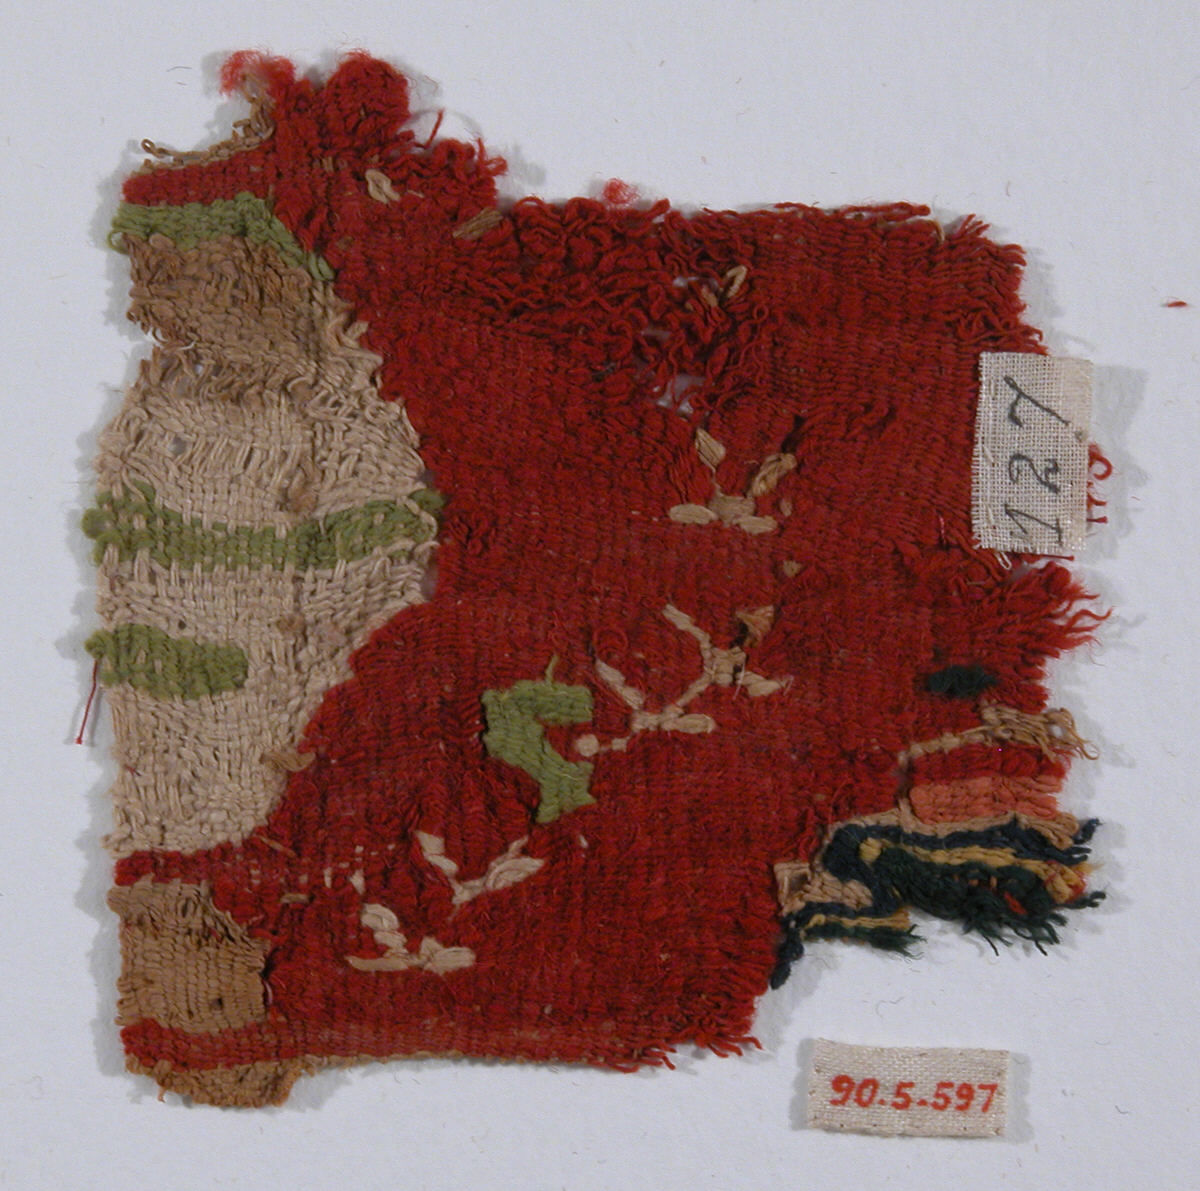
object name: textile fragment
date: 401-600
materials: linen, wool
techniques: weave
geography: egypt